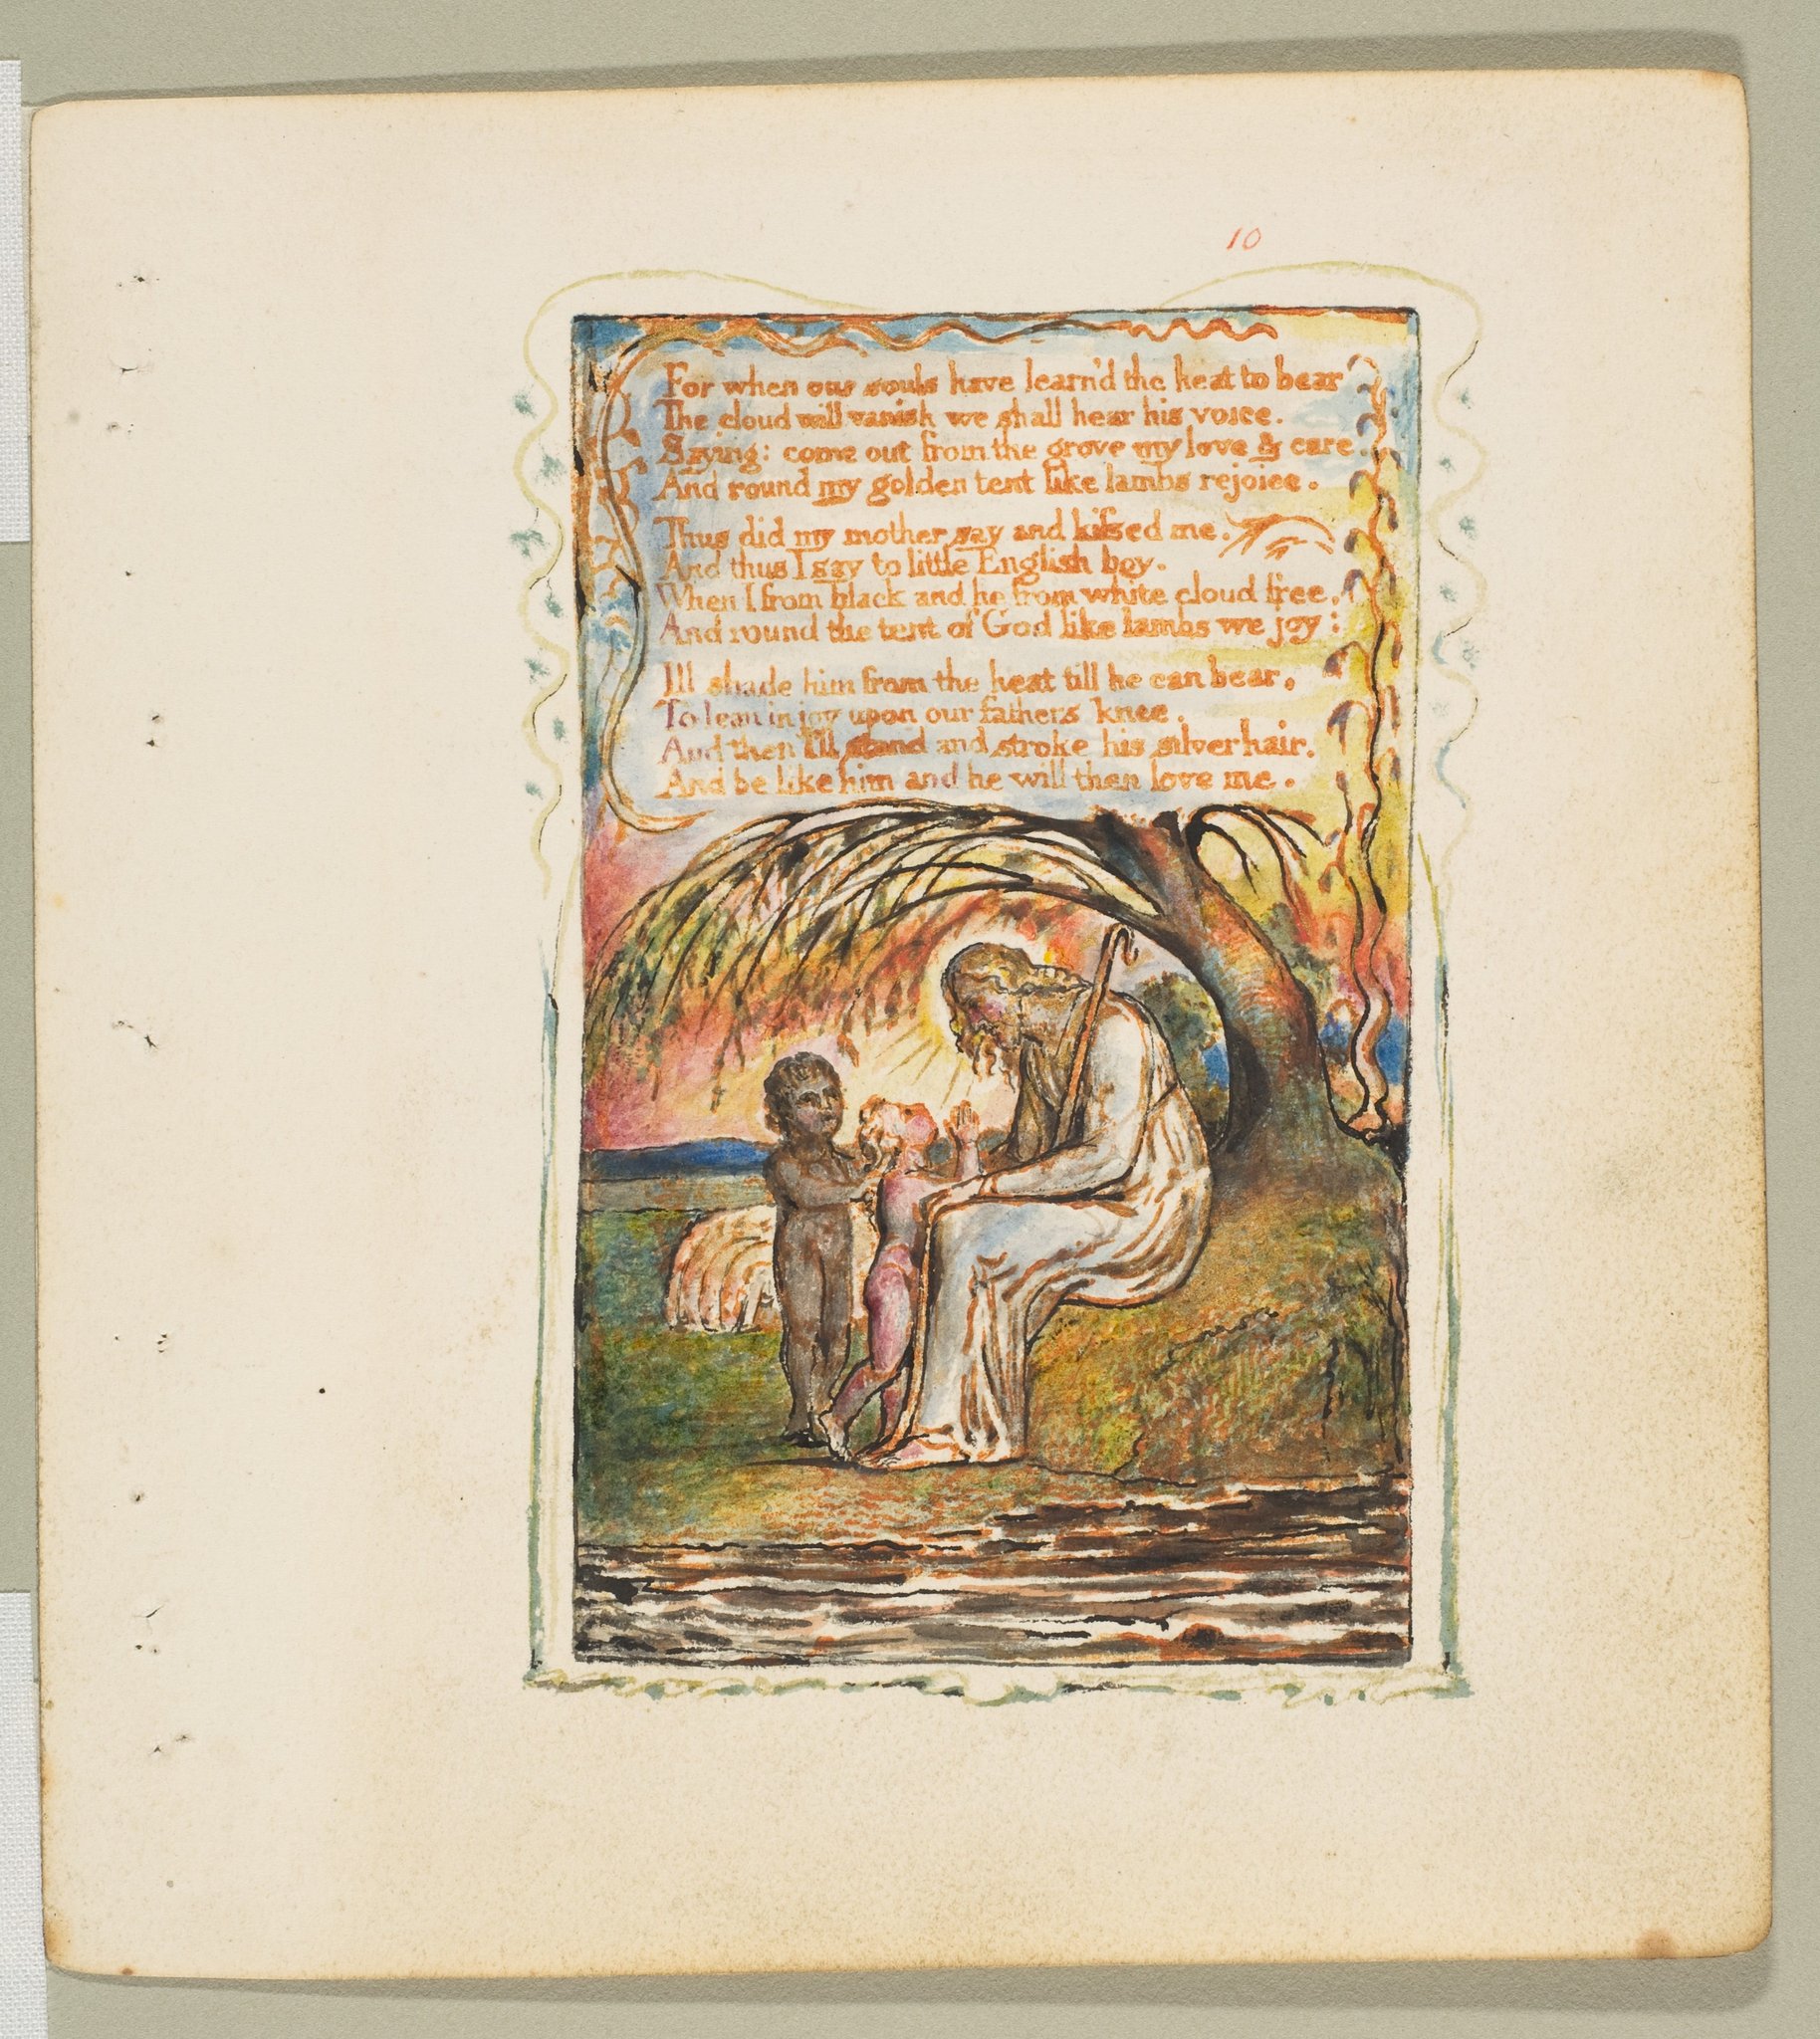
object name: print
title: Songs of Innocence: The Little Black Boy (second plate)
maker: william blake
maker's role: artist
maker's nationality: british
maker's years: 1757-1827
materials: gold, ink, shell, watercolor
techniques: etching, hand coloring, printing, relief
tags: poetry,boys,men